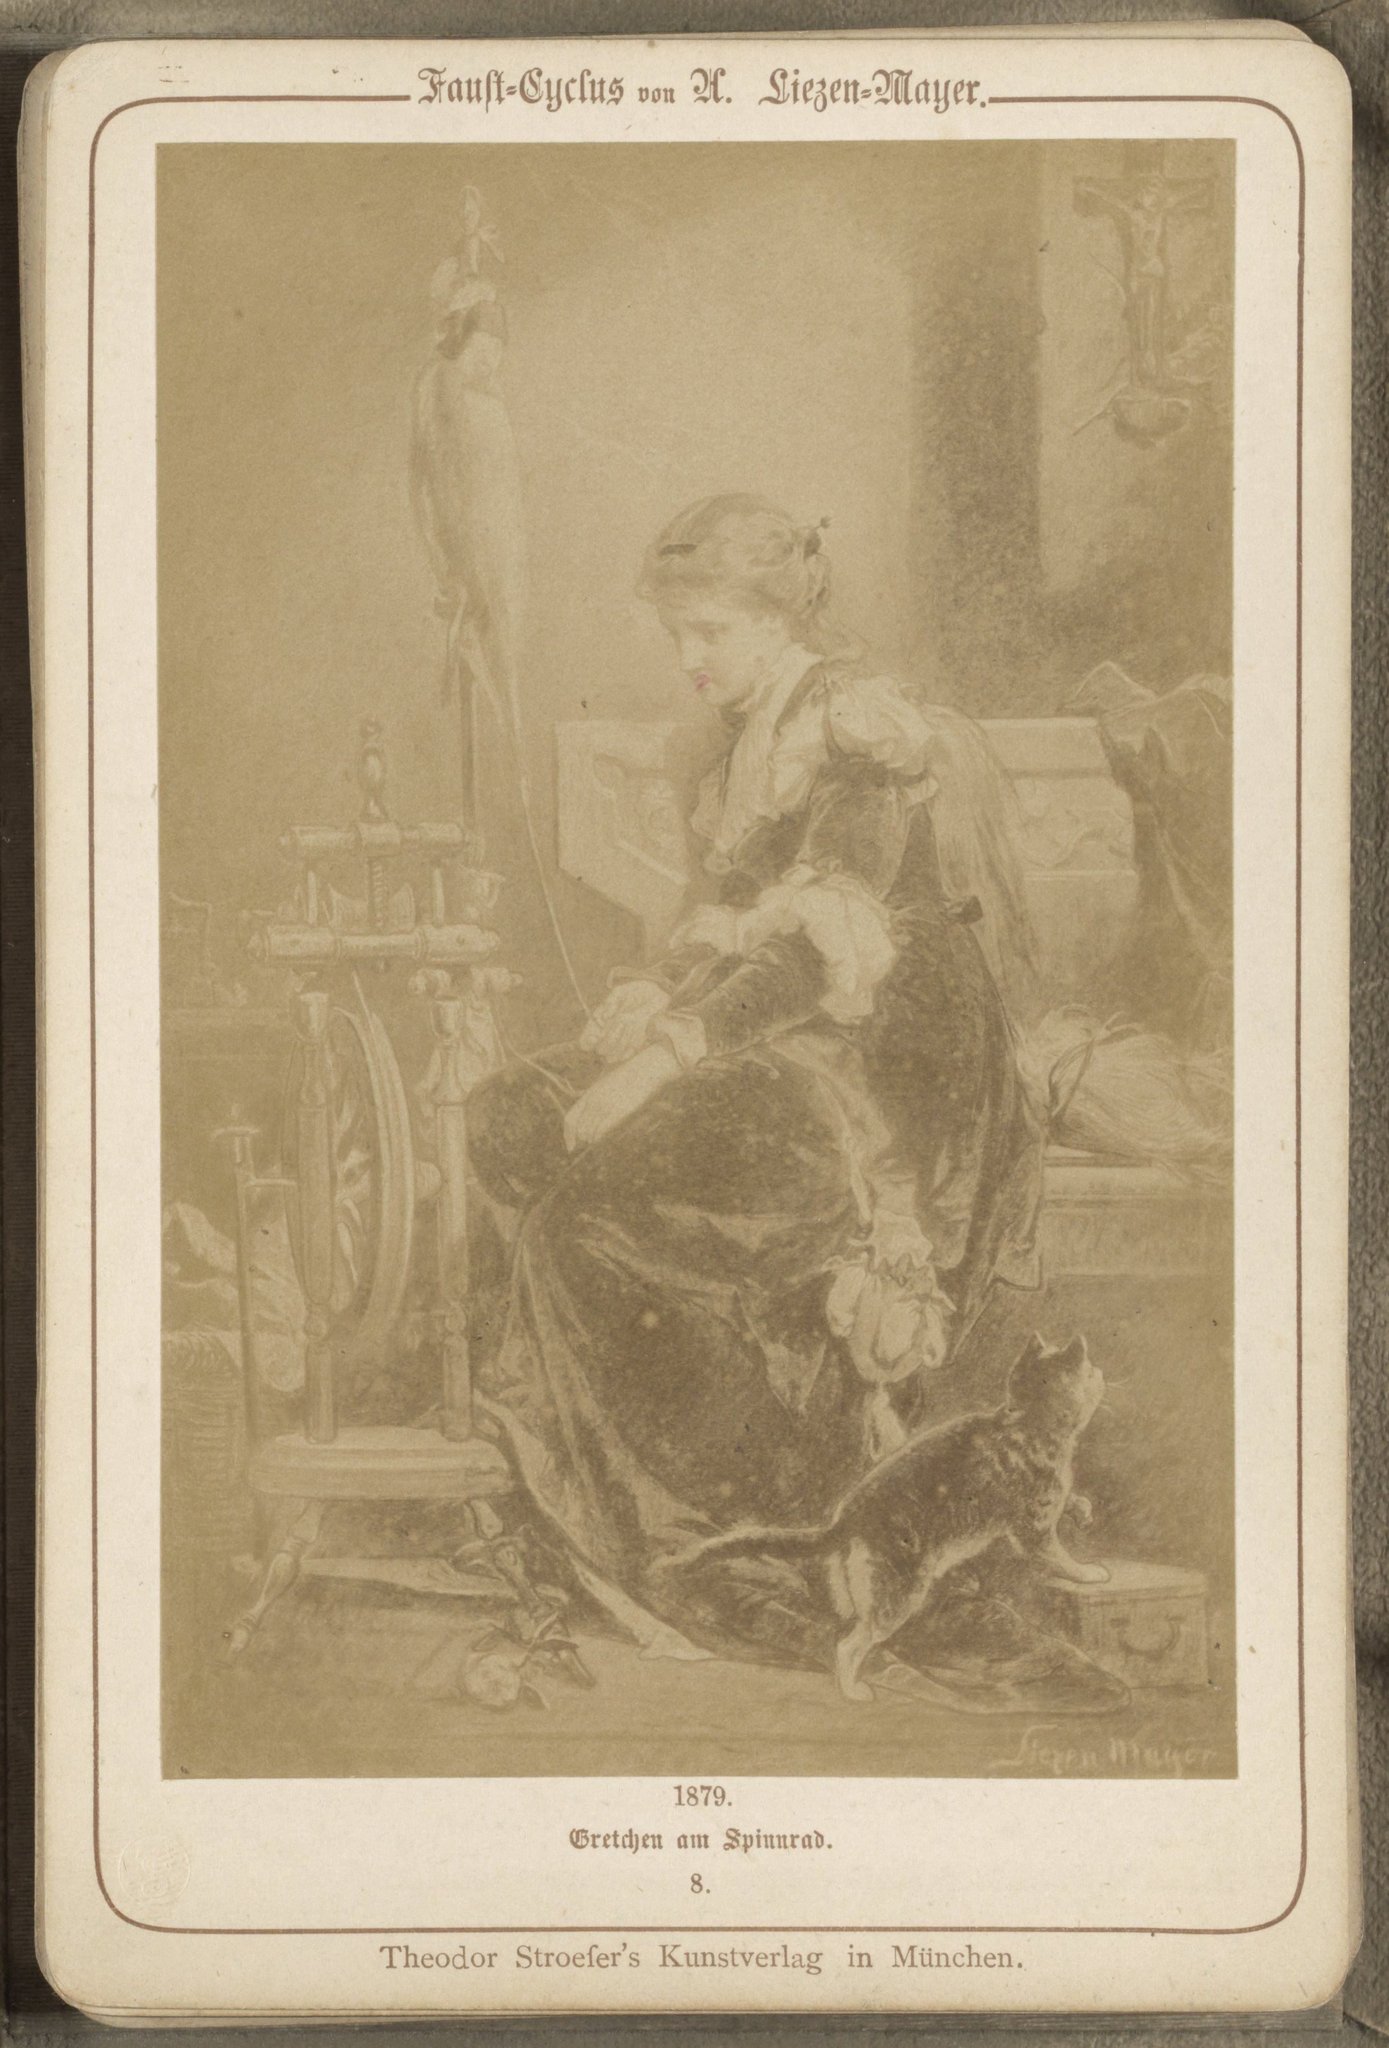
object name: photograph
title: Gretchen am Spinnrad.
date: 1879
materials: cardboard, paper, photographic support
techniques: albumen print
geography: munich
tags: cat, gretchen, spinning-wheel, faust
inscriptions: check stamp: ‘TS’, number: ‘8’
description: Onderdeel van Album met 30 fotoreproducties van tekeningen van het Faust-verhaal van J.W. von Goethe.